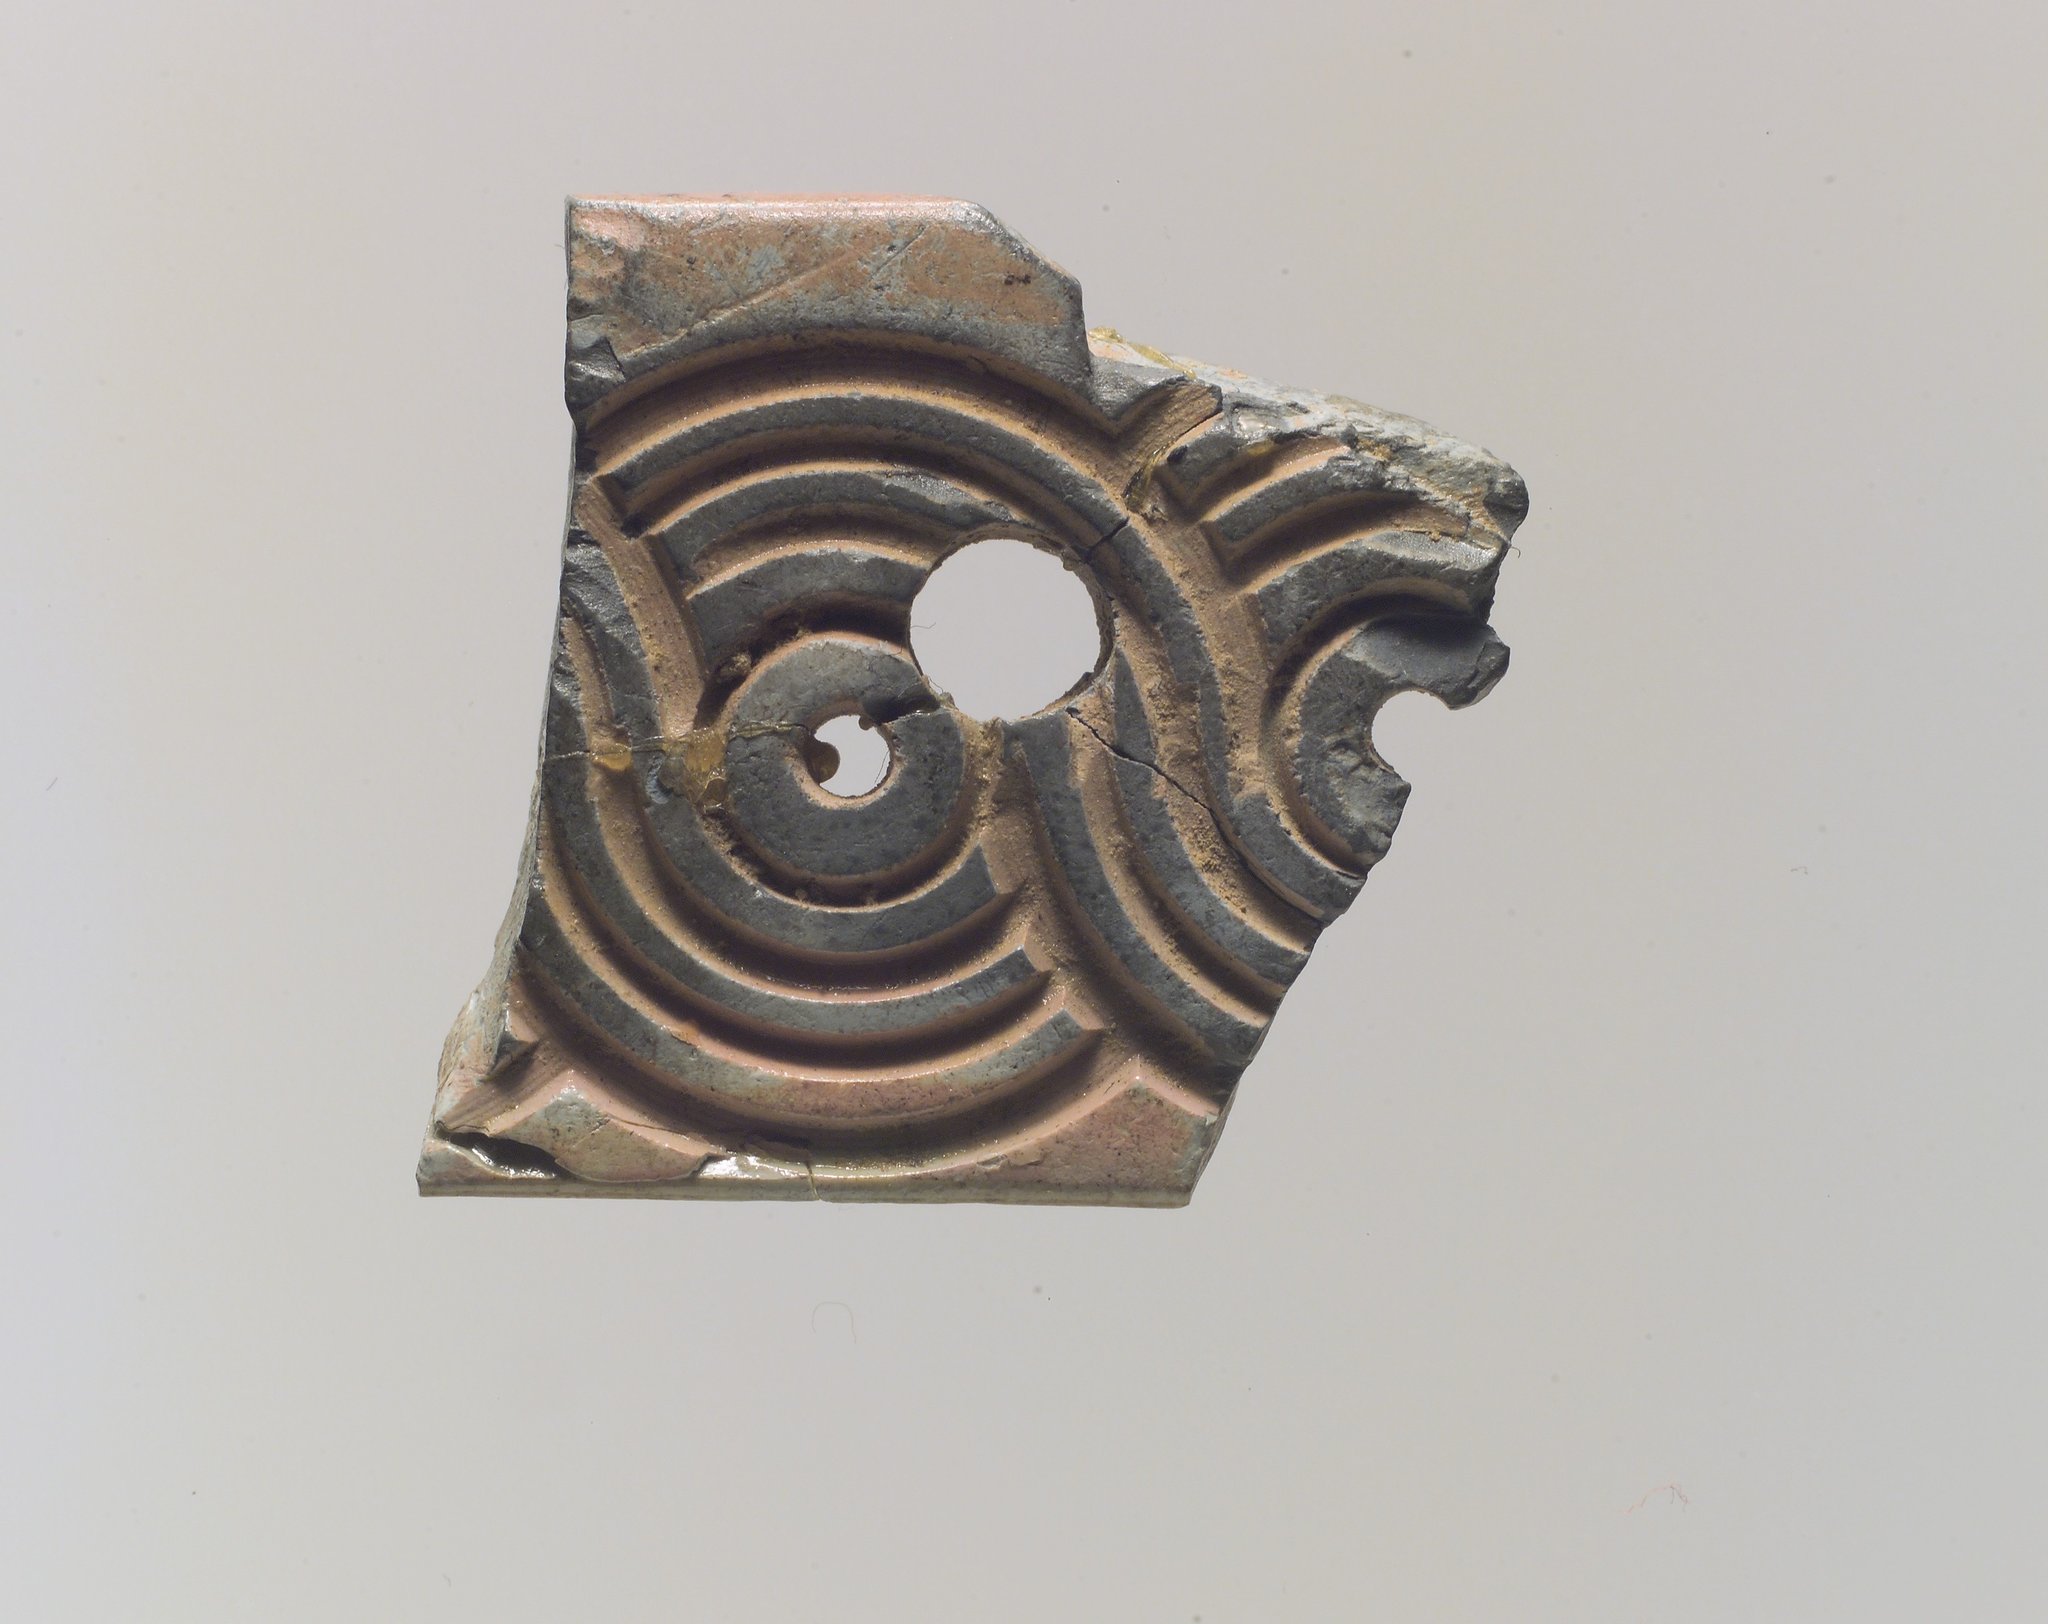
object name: relief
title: Plaque fragment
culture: assyrian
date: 1800-1701 BCE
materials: ivory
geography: anatolia